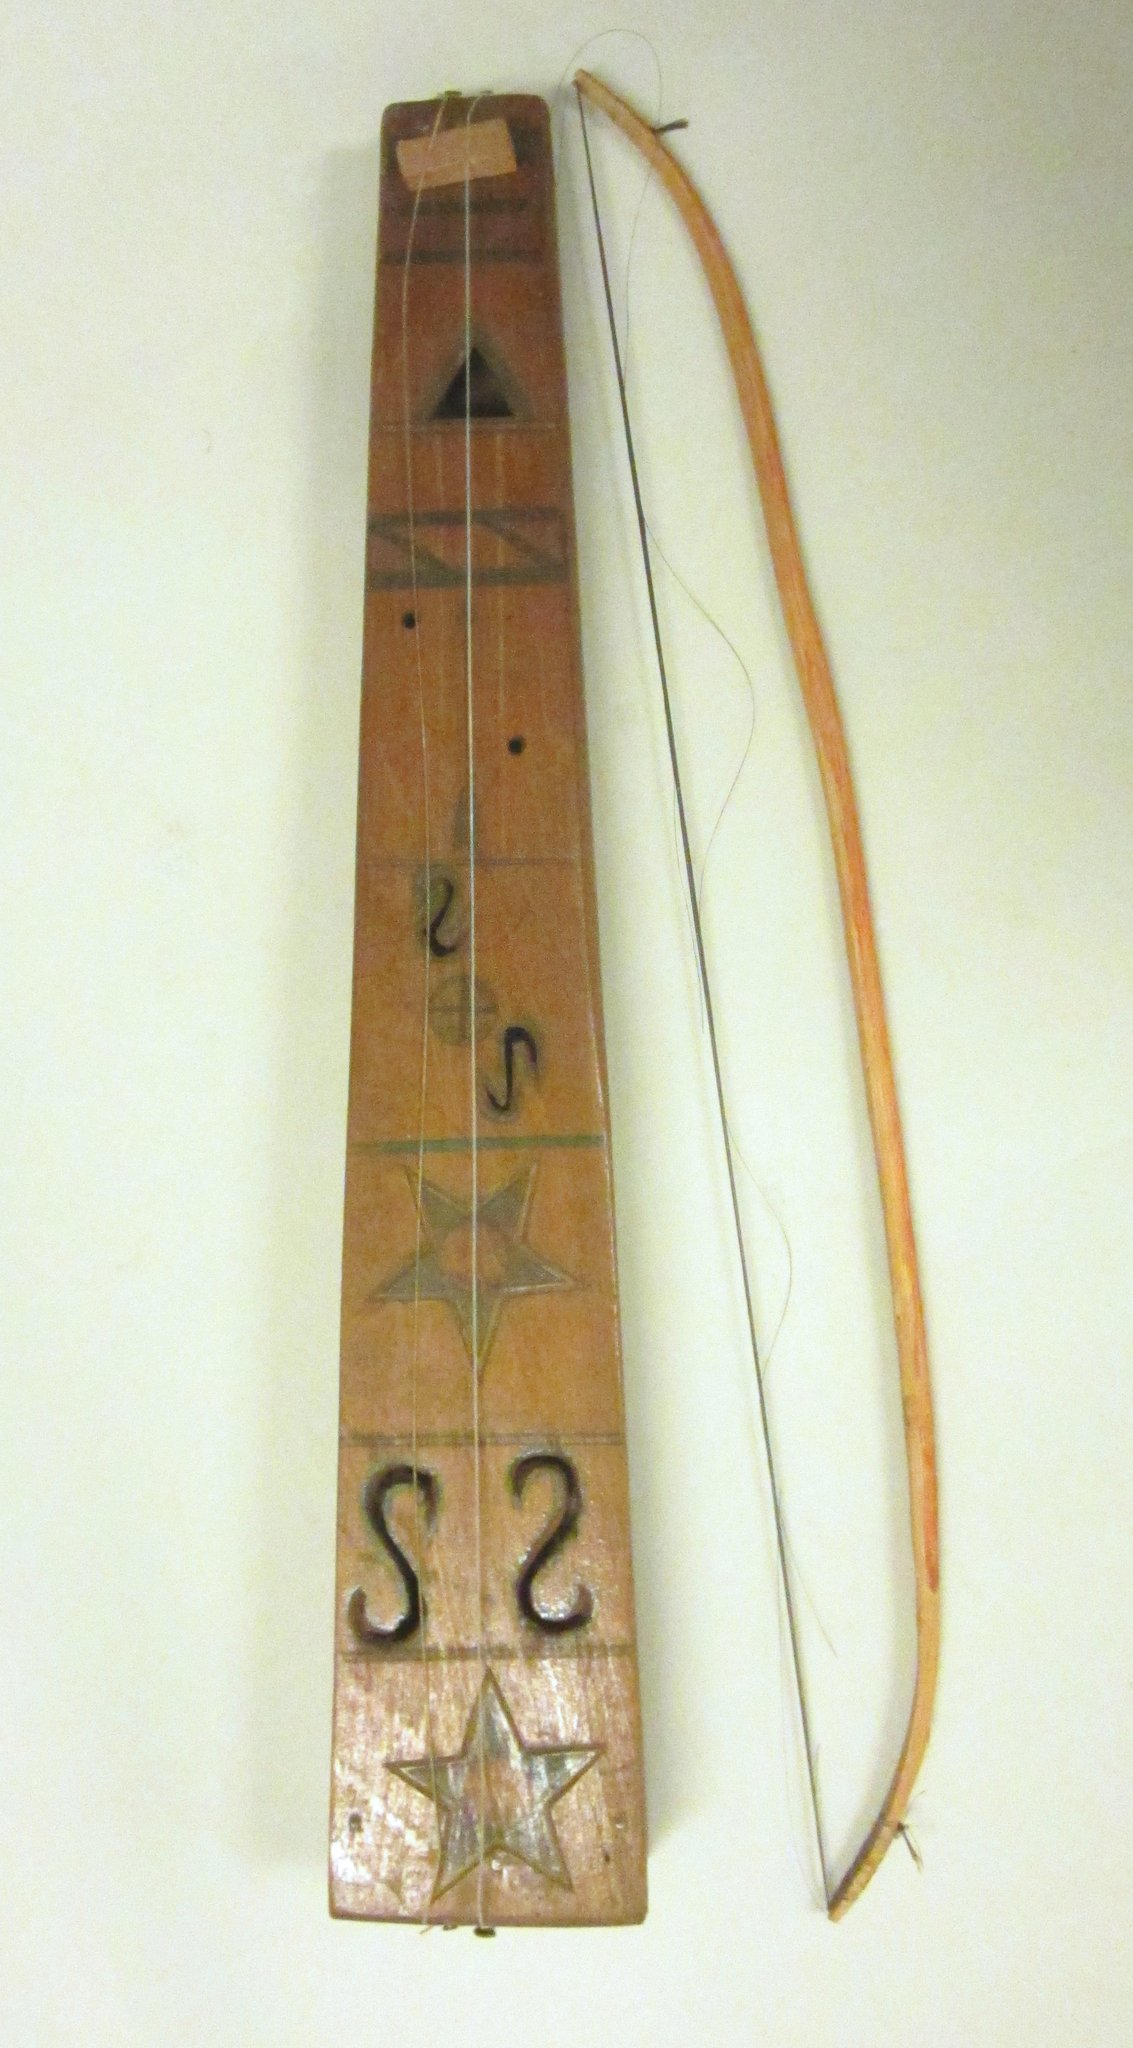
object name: tsii' edo' ai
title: Tsii' Edo' Ai (bowed zither) Apache Fiddle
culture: native american, apache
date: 1900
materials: hair, metal, paint, wood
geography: united states